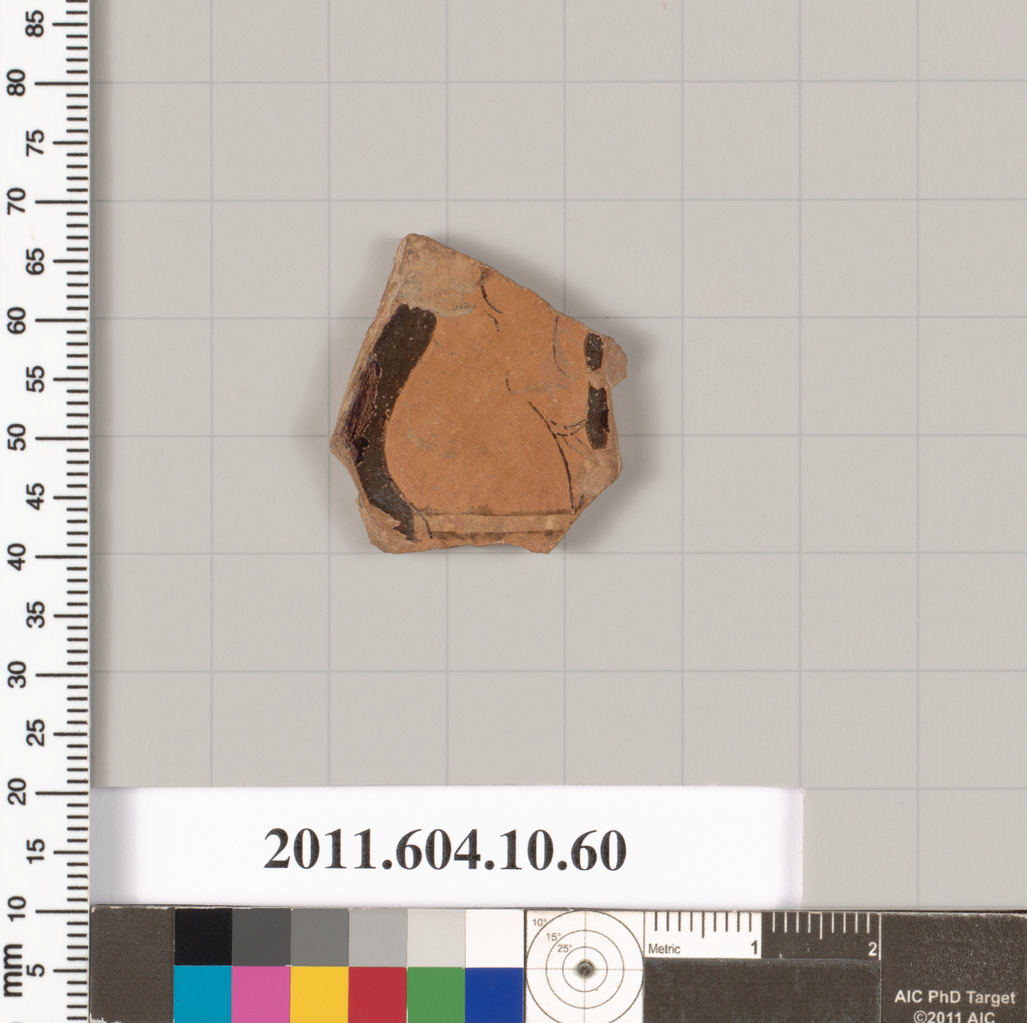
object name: kylix fragment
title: Terracotta fragment of a kylix (drinking cup)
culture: etruscan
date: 334-301 BCE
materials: terracotta